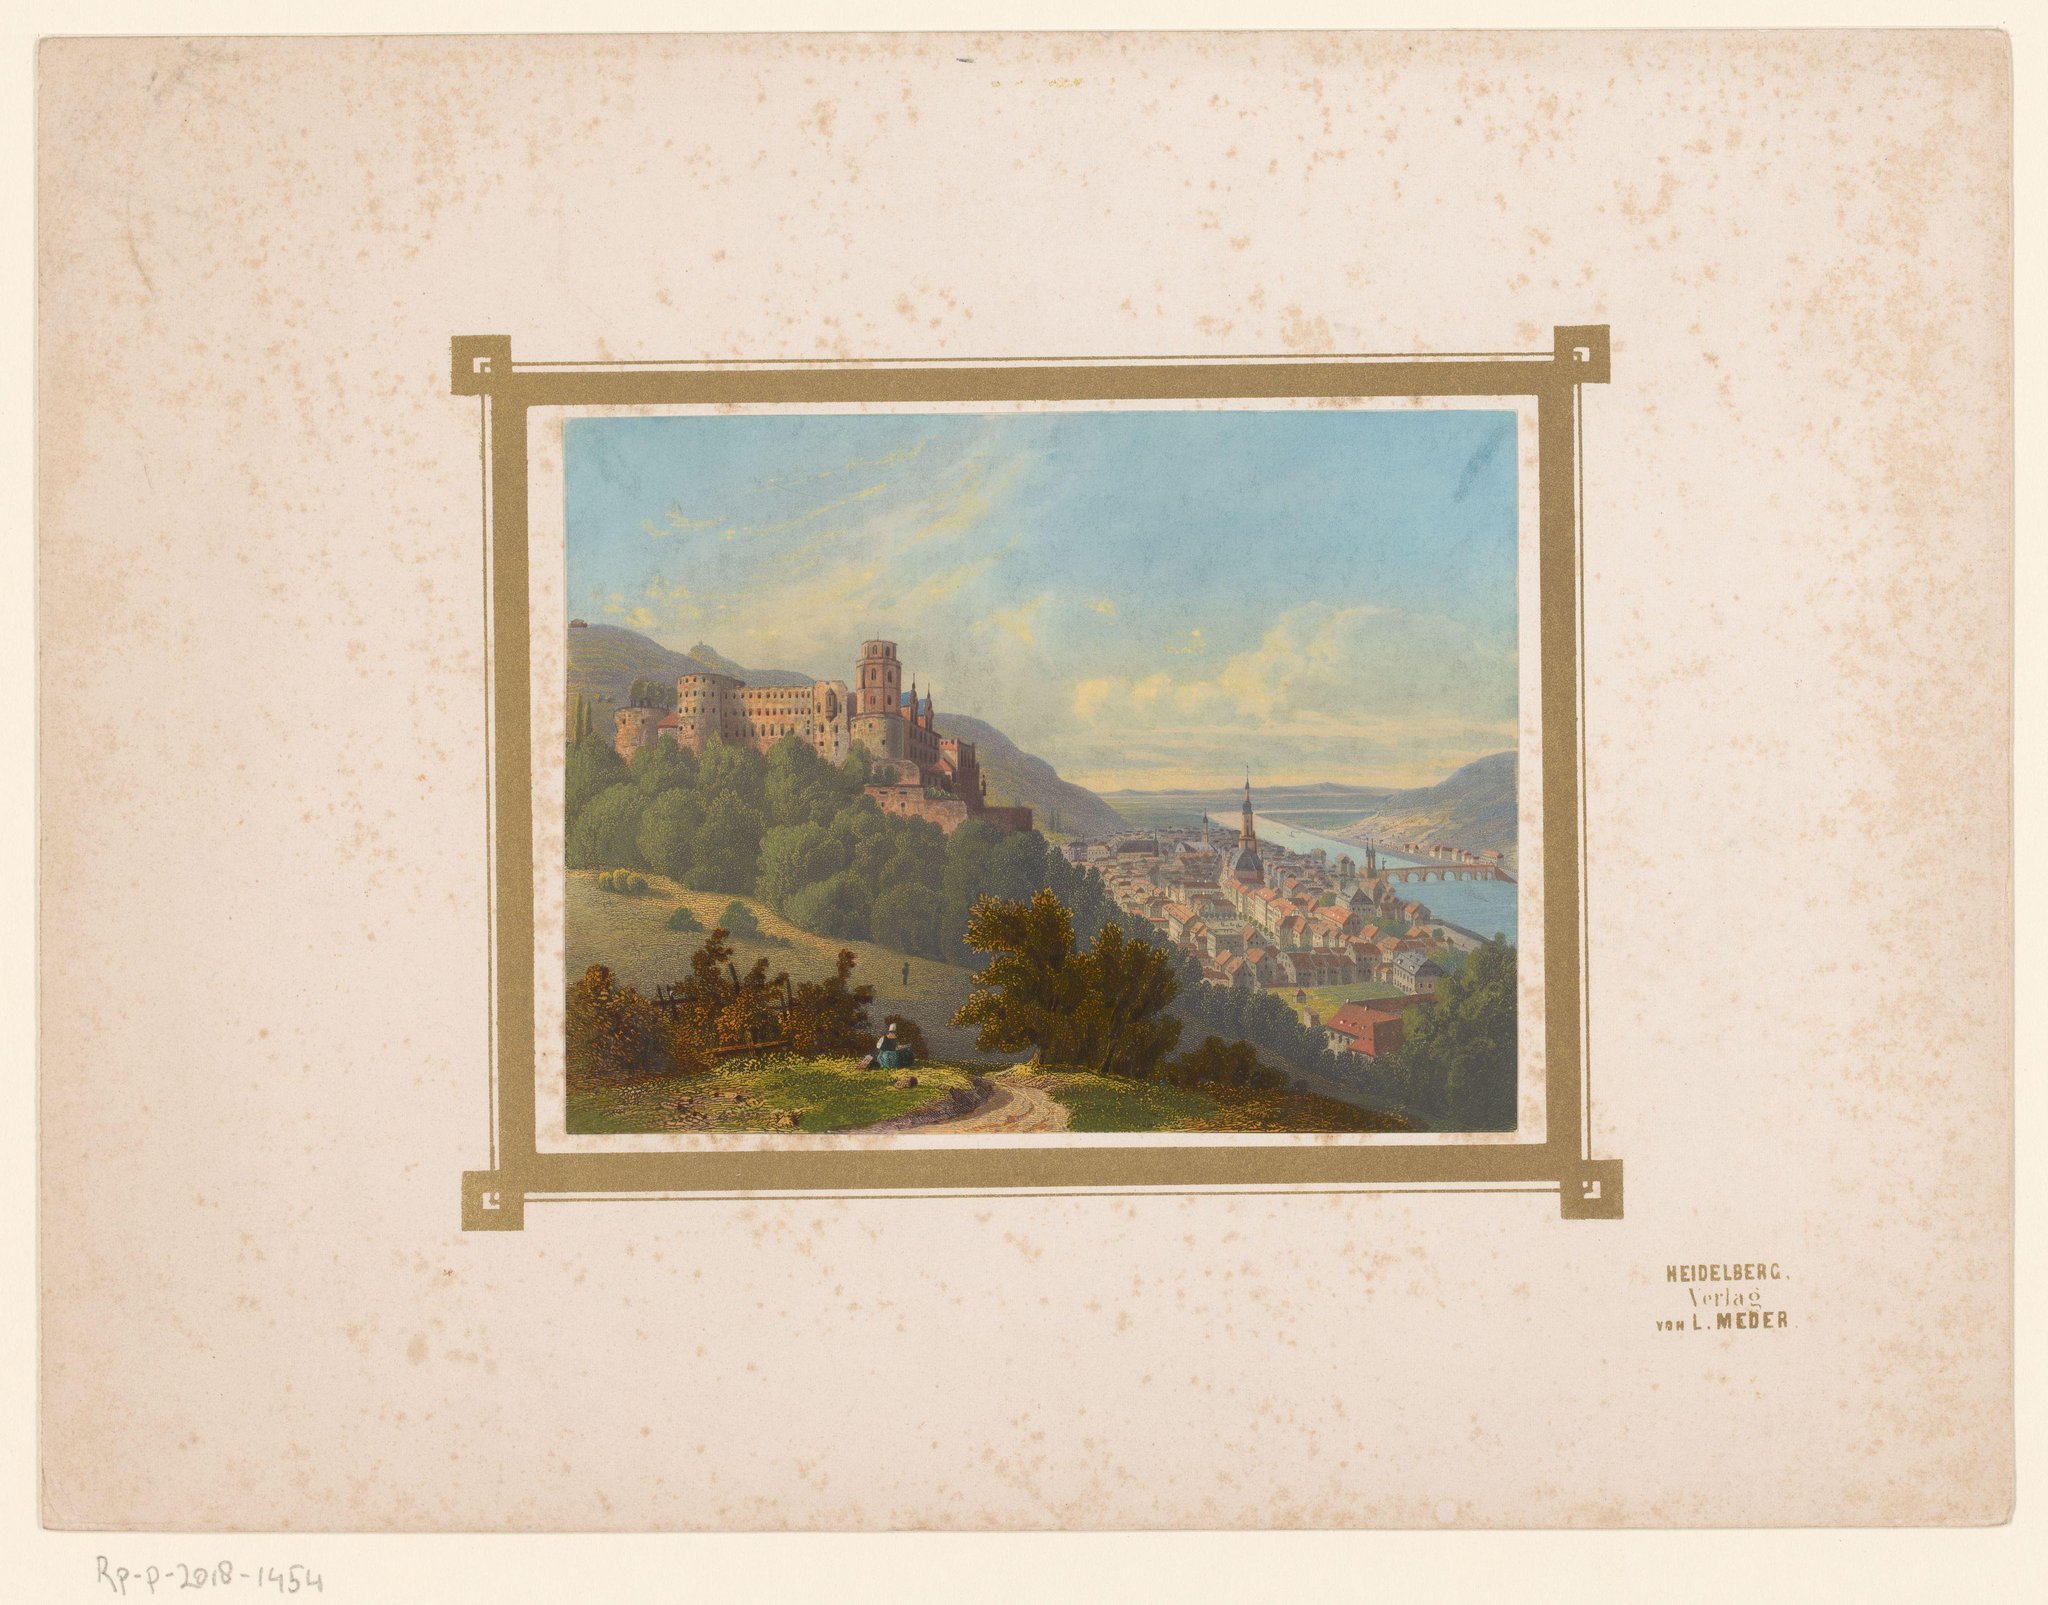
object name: print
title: Gezicht op Heidelberg en Schloss Heidelberg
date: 1850-1899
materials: paper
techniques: etching, hand coloring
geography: heidelberg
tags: prospect of city, town panorama, silhouette of city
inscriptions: collector's mark: Lugt 2228